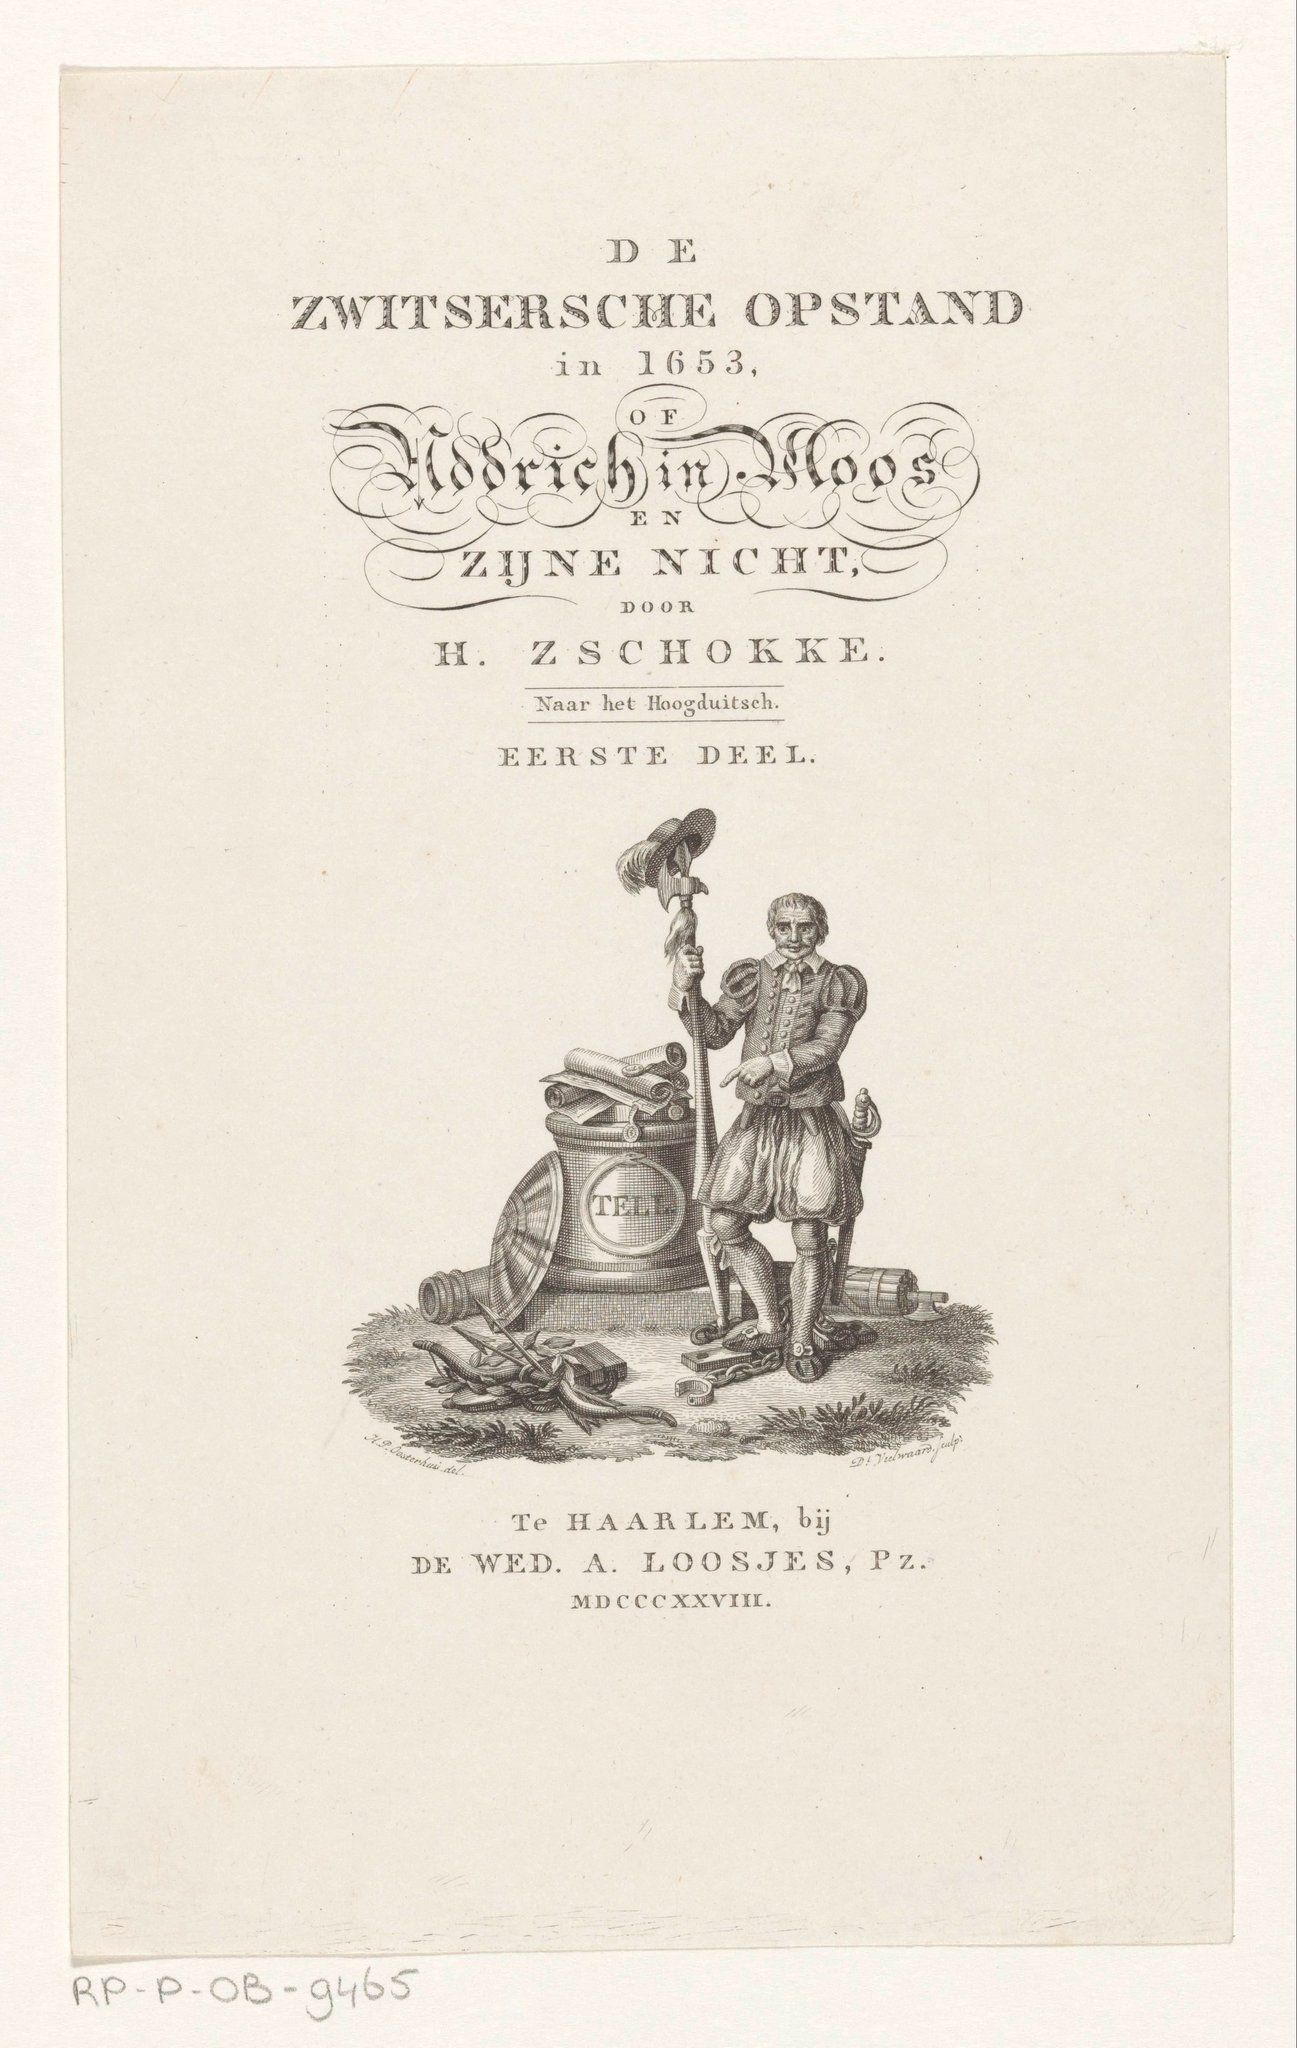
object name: titelblad, titelpagina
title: Titelpagina voor: H. Zschokke, De zwitsersche opstand in 1653, 1828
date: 1828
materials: paper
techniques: engraving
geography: haarlem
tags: farmers, revolution, revolt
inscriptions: collector's mark: Lugt 2228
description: Een man staat met een speer met hoed naast een altaar met boekrollen. Aan de voorzijde van het altaar vormt de slang Ourobouros een medaillon met de naam Tell. Rondom liggen diverse wapens. De allegorie verwijst naar de Zwitserse vrijheidsheld Willem Tell die in de 14e eeuw weigerde een hoed op een staak te groeten, waarbij de hoed centraal stond voor het heersende vorstengeslacht.